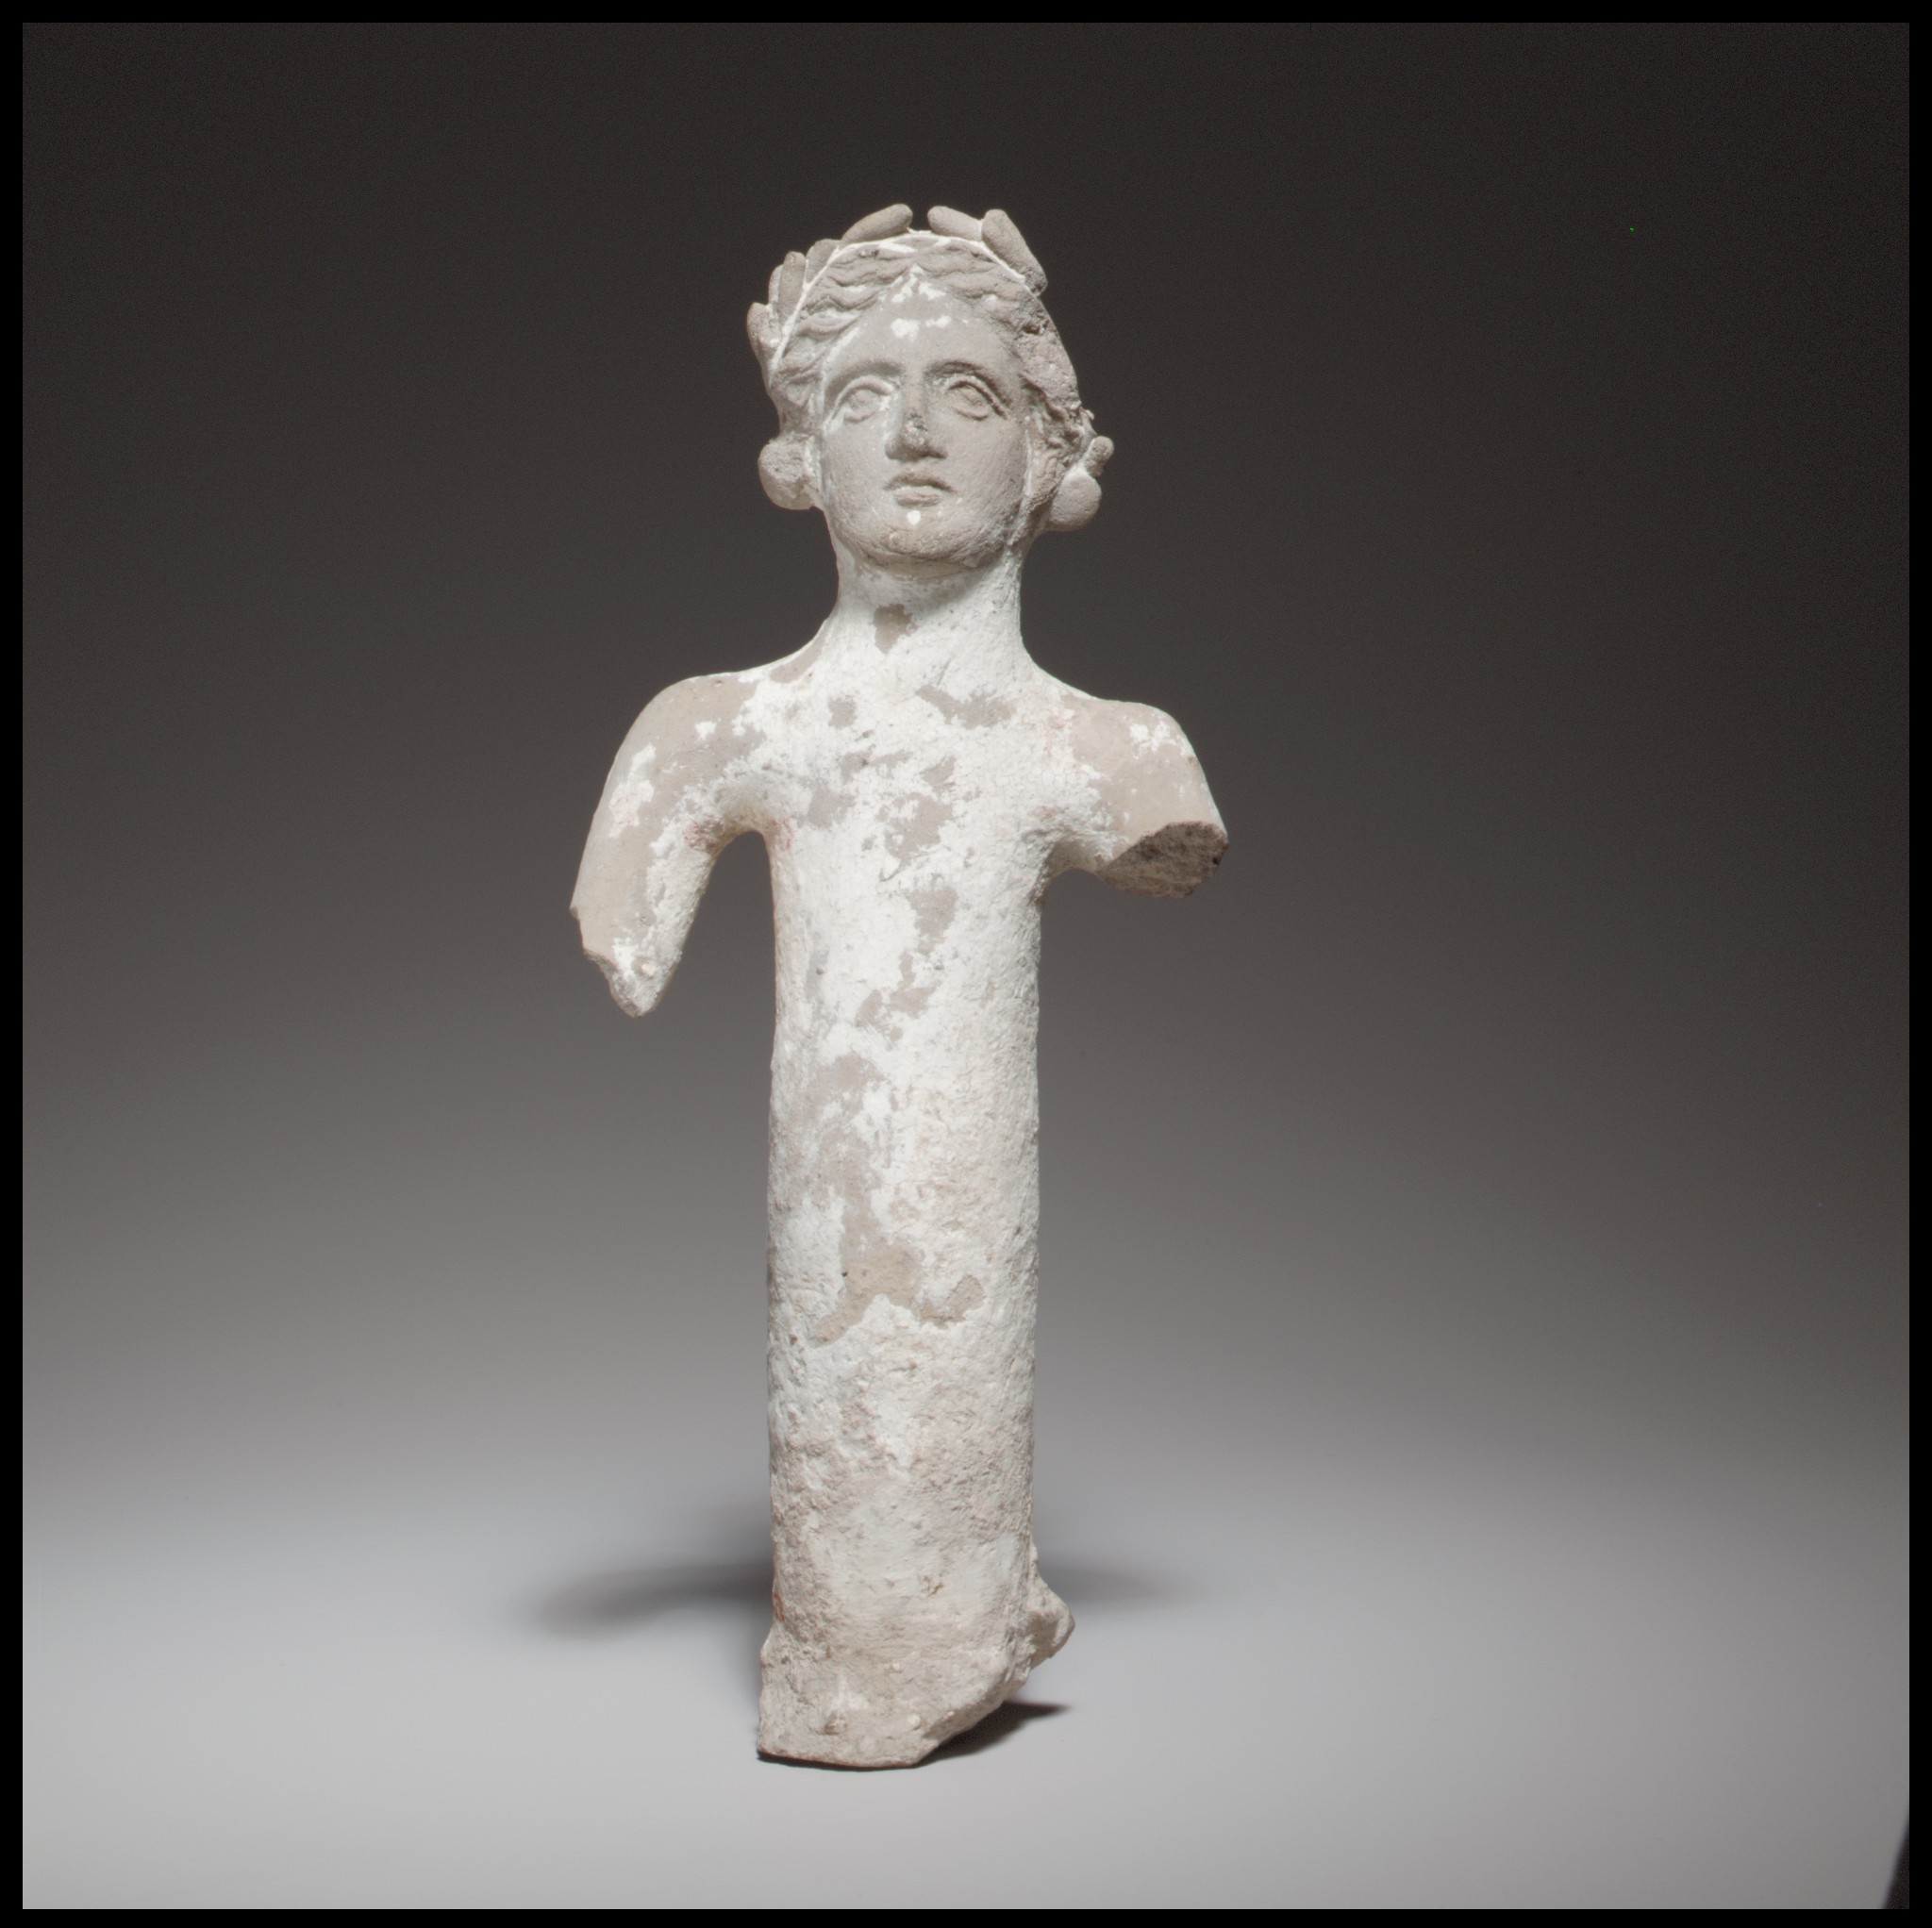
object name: statuette of a female from a ring dance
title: Charioteer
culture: cypriot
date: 400-301 BCE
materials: terracotta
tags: men